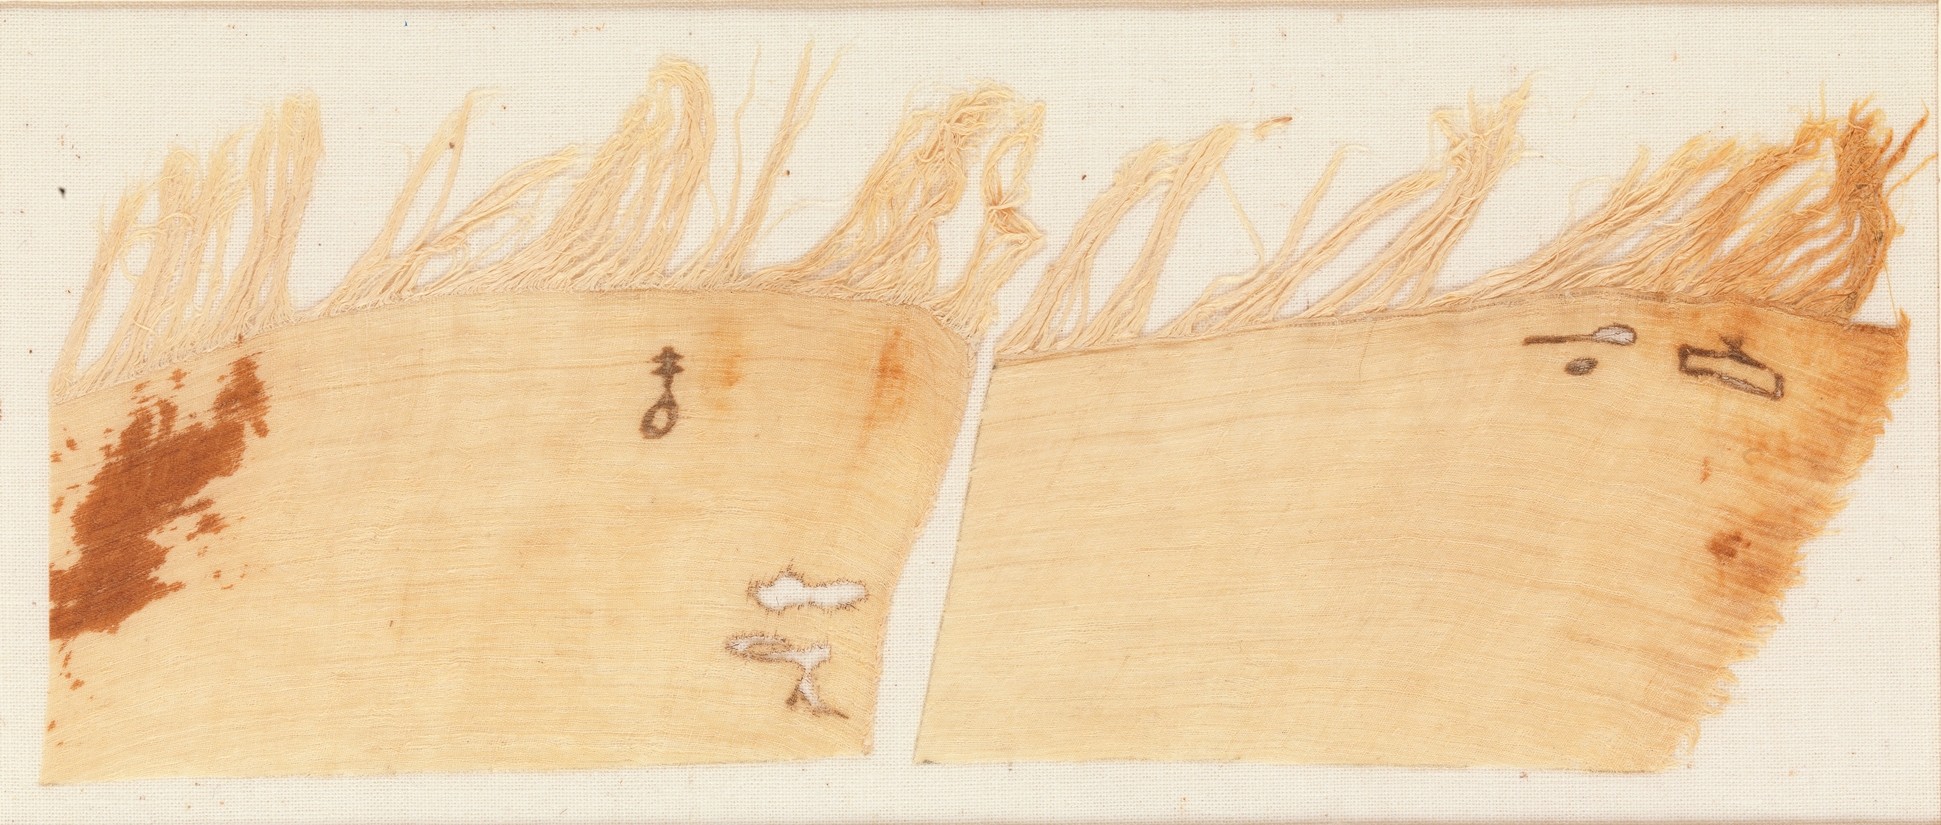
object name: linen mark, wah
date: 1981-1975 BCE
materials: linen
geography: egypt